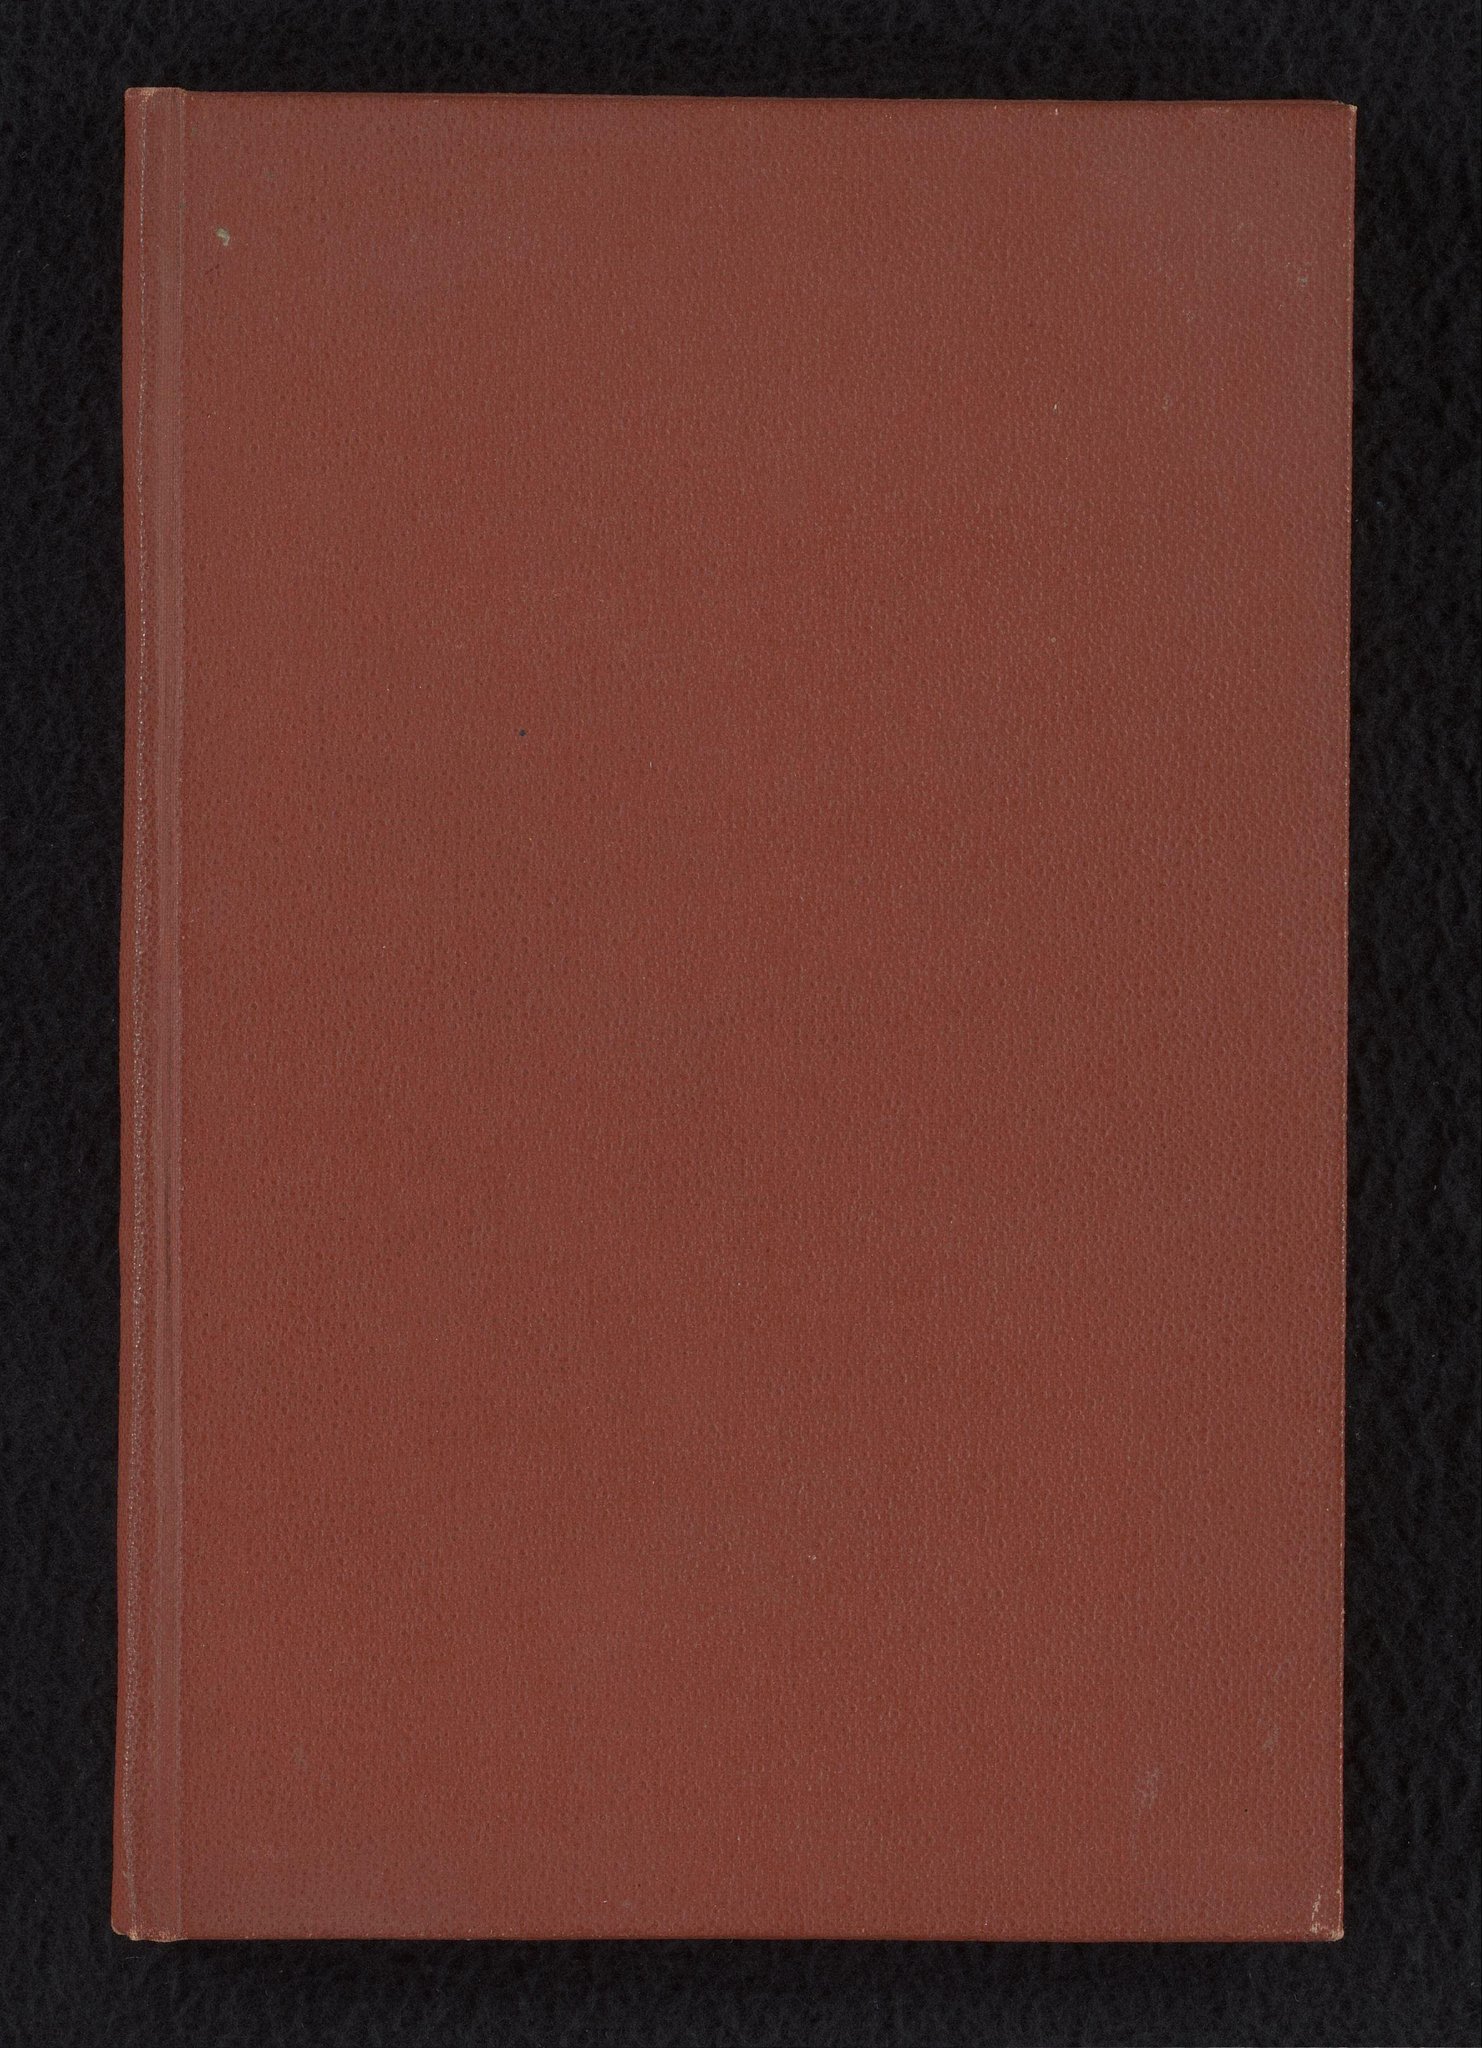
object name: photograph album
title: Poëziealbum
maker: Anonymous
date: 1880-1885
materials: linen, paper, photographic support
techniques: albumen print, decorated paper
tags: adolescent, young woman, maiden, historical persons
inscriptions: inscription: ‘Dienst/ Verspreide/ Rijkskollekties (...)’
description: Poëziealbum met 1 foto, een portret geplaatst bij de signatuur van A. Vermer.